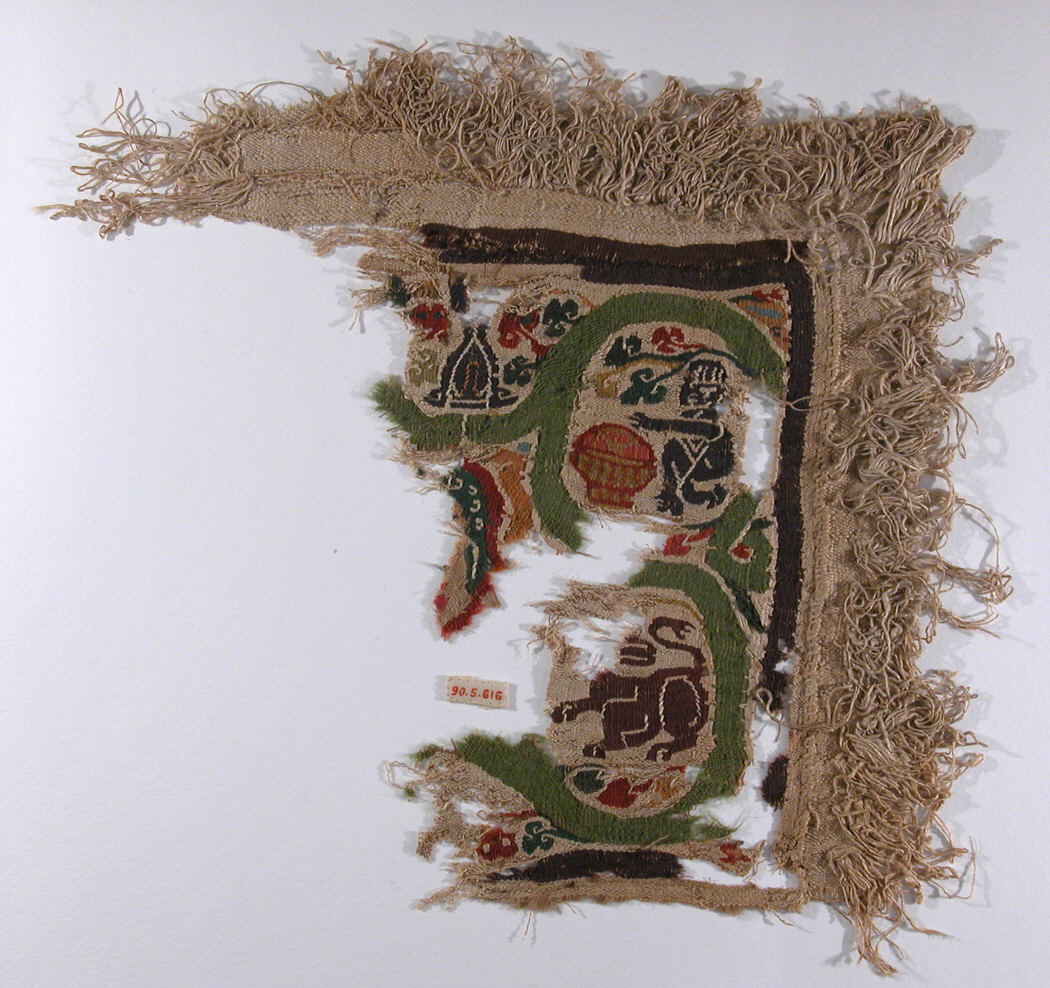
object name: textile fragment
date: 301-400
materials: linen, wool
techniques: weave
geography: egypt